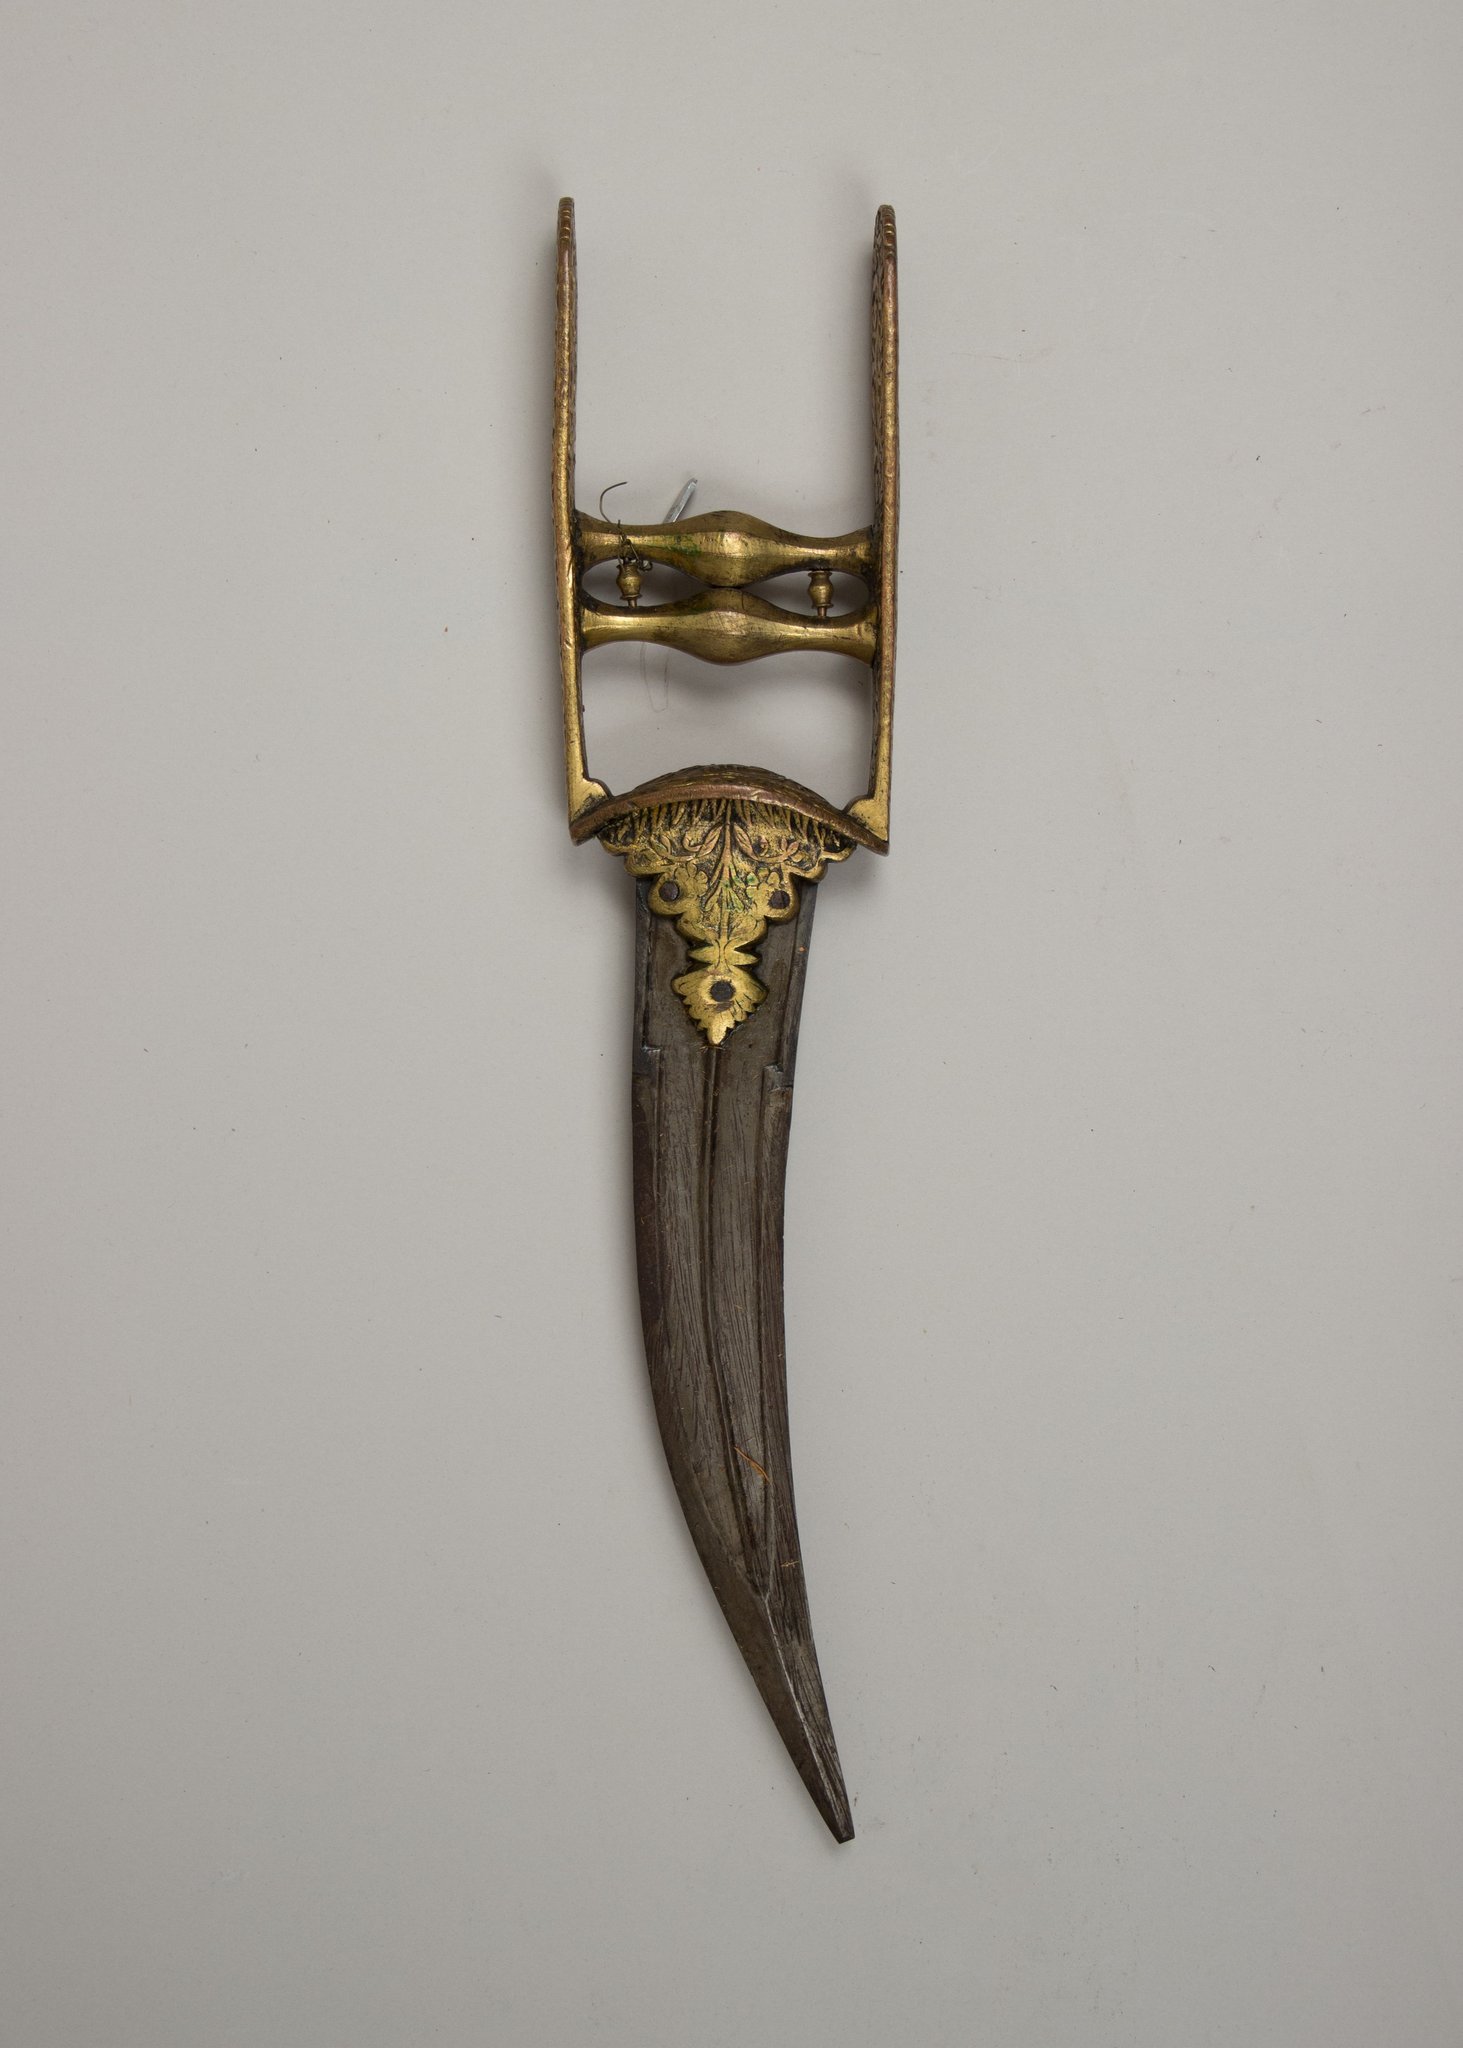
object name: dagger katar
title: Dagger (Katar)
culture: indian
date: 1701-1800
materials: copper, steel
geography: india